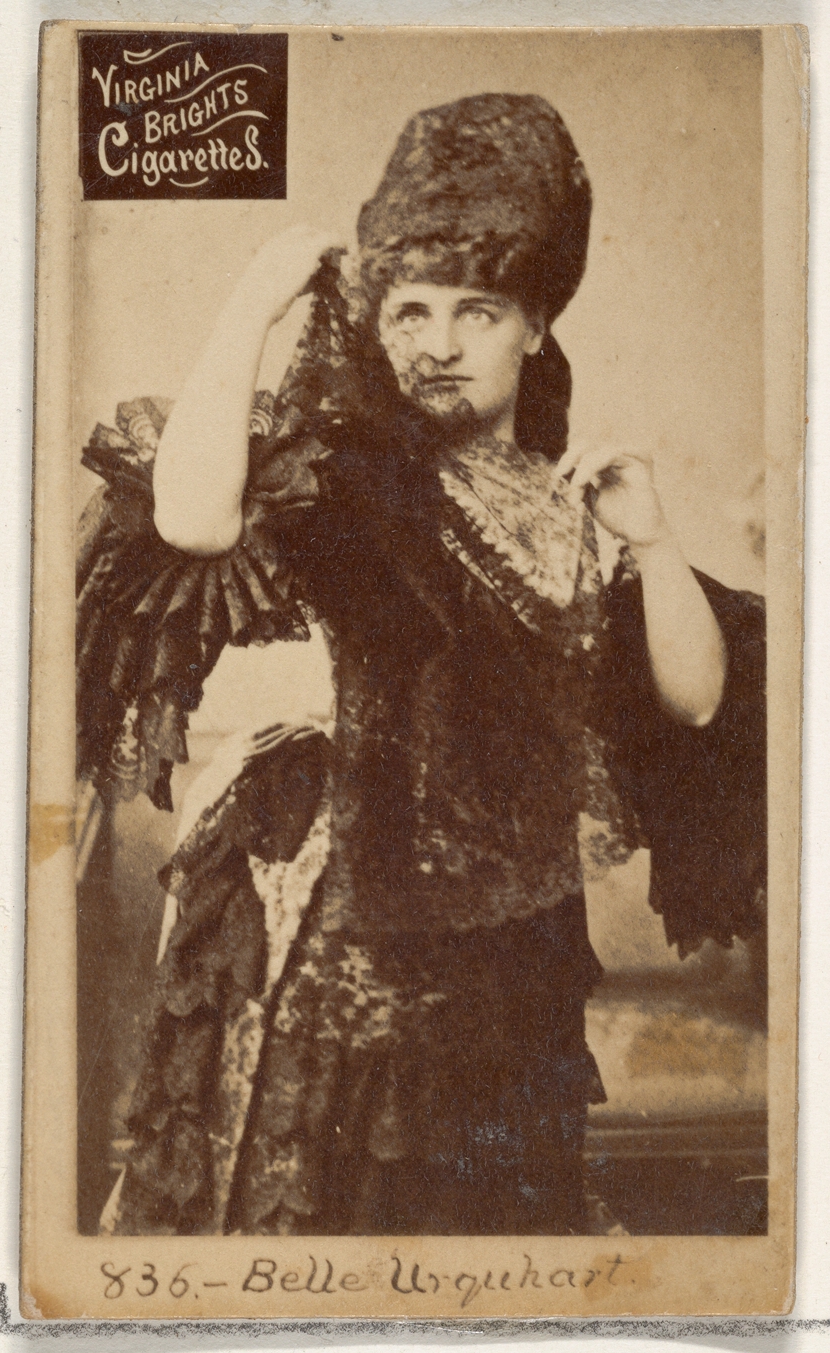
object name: photograph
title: Card 836, Belle Urquhart, from the Actors and Actresses series (N45, Type 2) for Virginia Brights Cigarettes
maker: allen & ginter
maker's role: publisher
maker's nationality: american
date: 1888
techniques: albumen silver print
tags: portraits,women,actresses